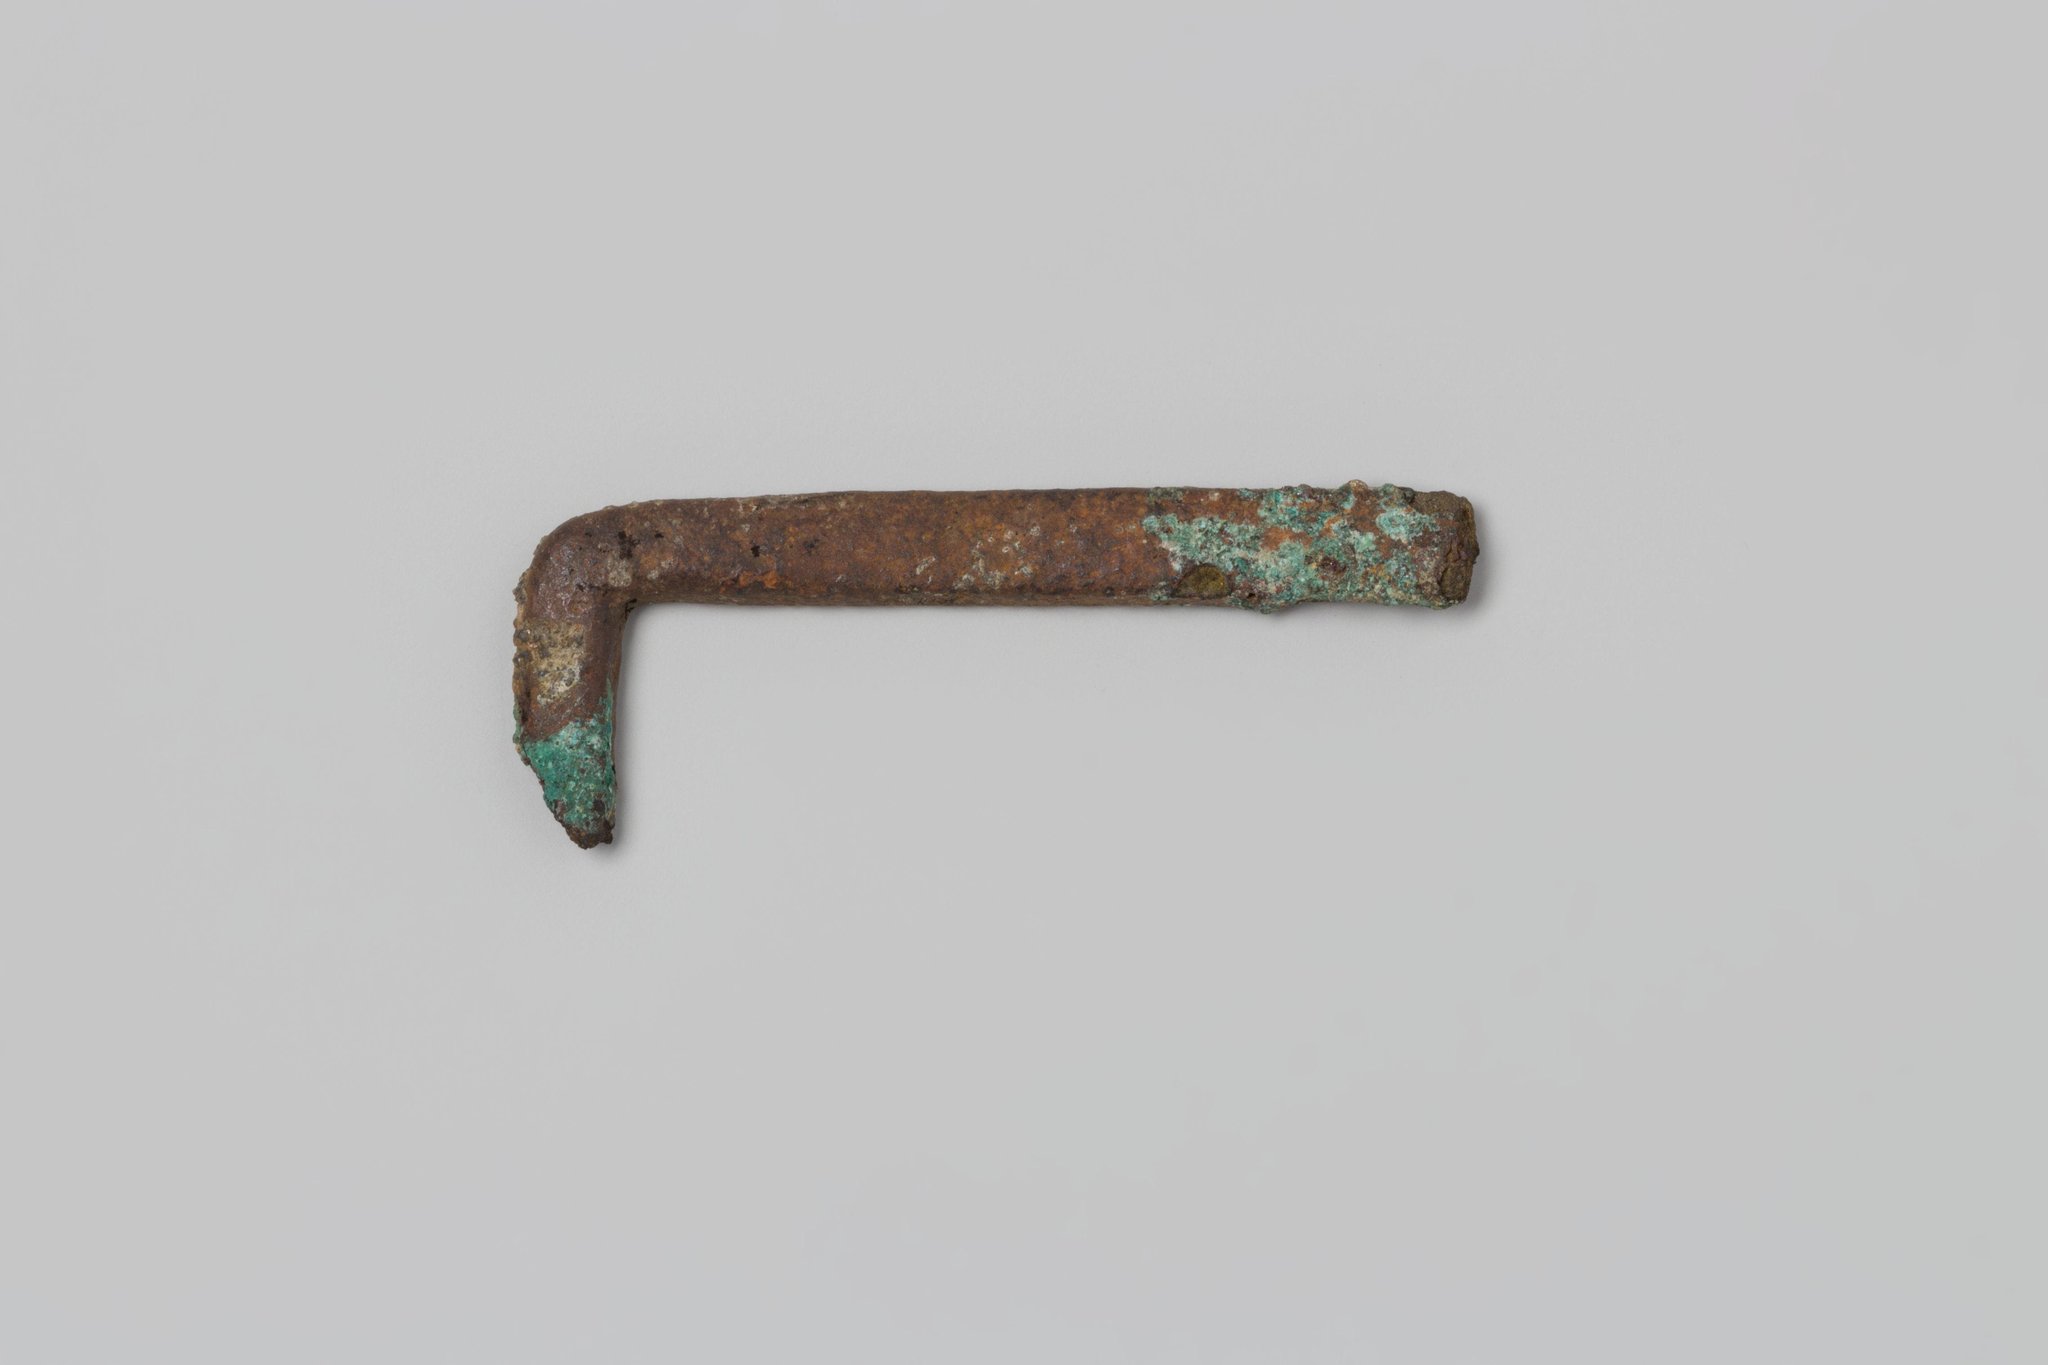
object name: belt buckle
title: Fragment riemgesp uit het wrak van de Oost-Indiëvaarder Hollandia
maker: Anonymous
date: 1700-1743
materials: copper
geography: netherlands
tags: verenigde oostindische compagnie, hollandia (schip), annet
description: Rectangular, fragm of ring, id. NG 1980-27H2796, belt buckle.